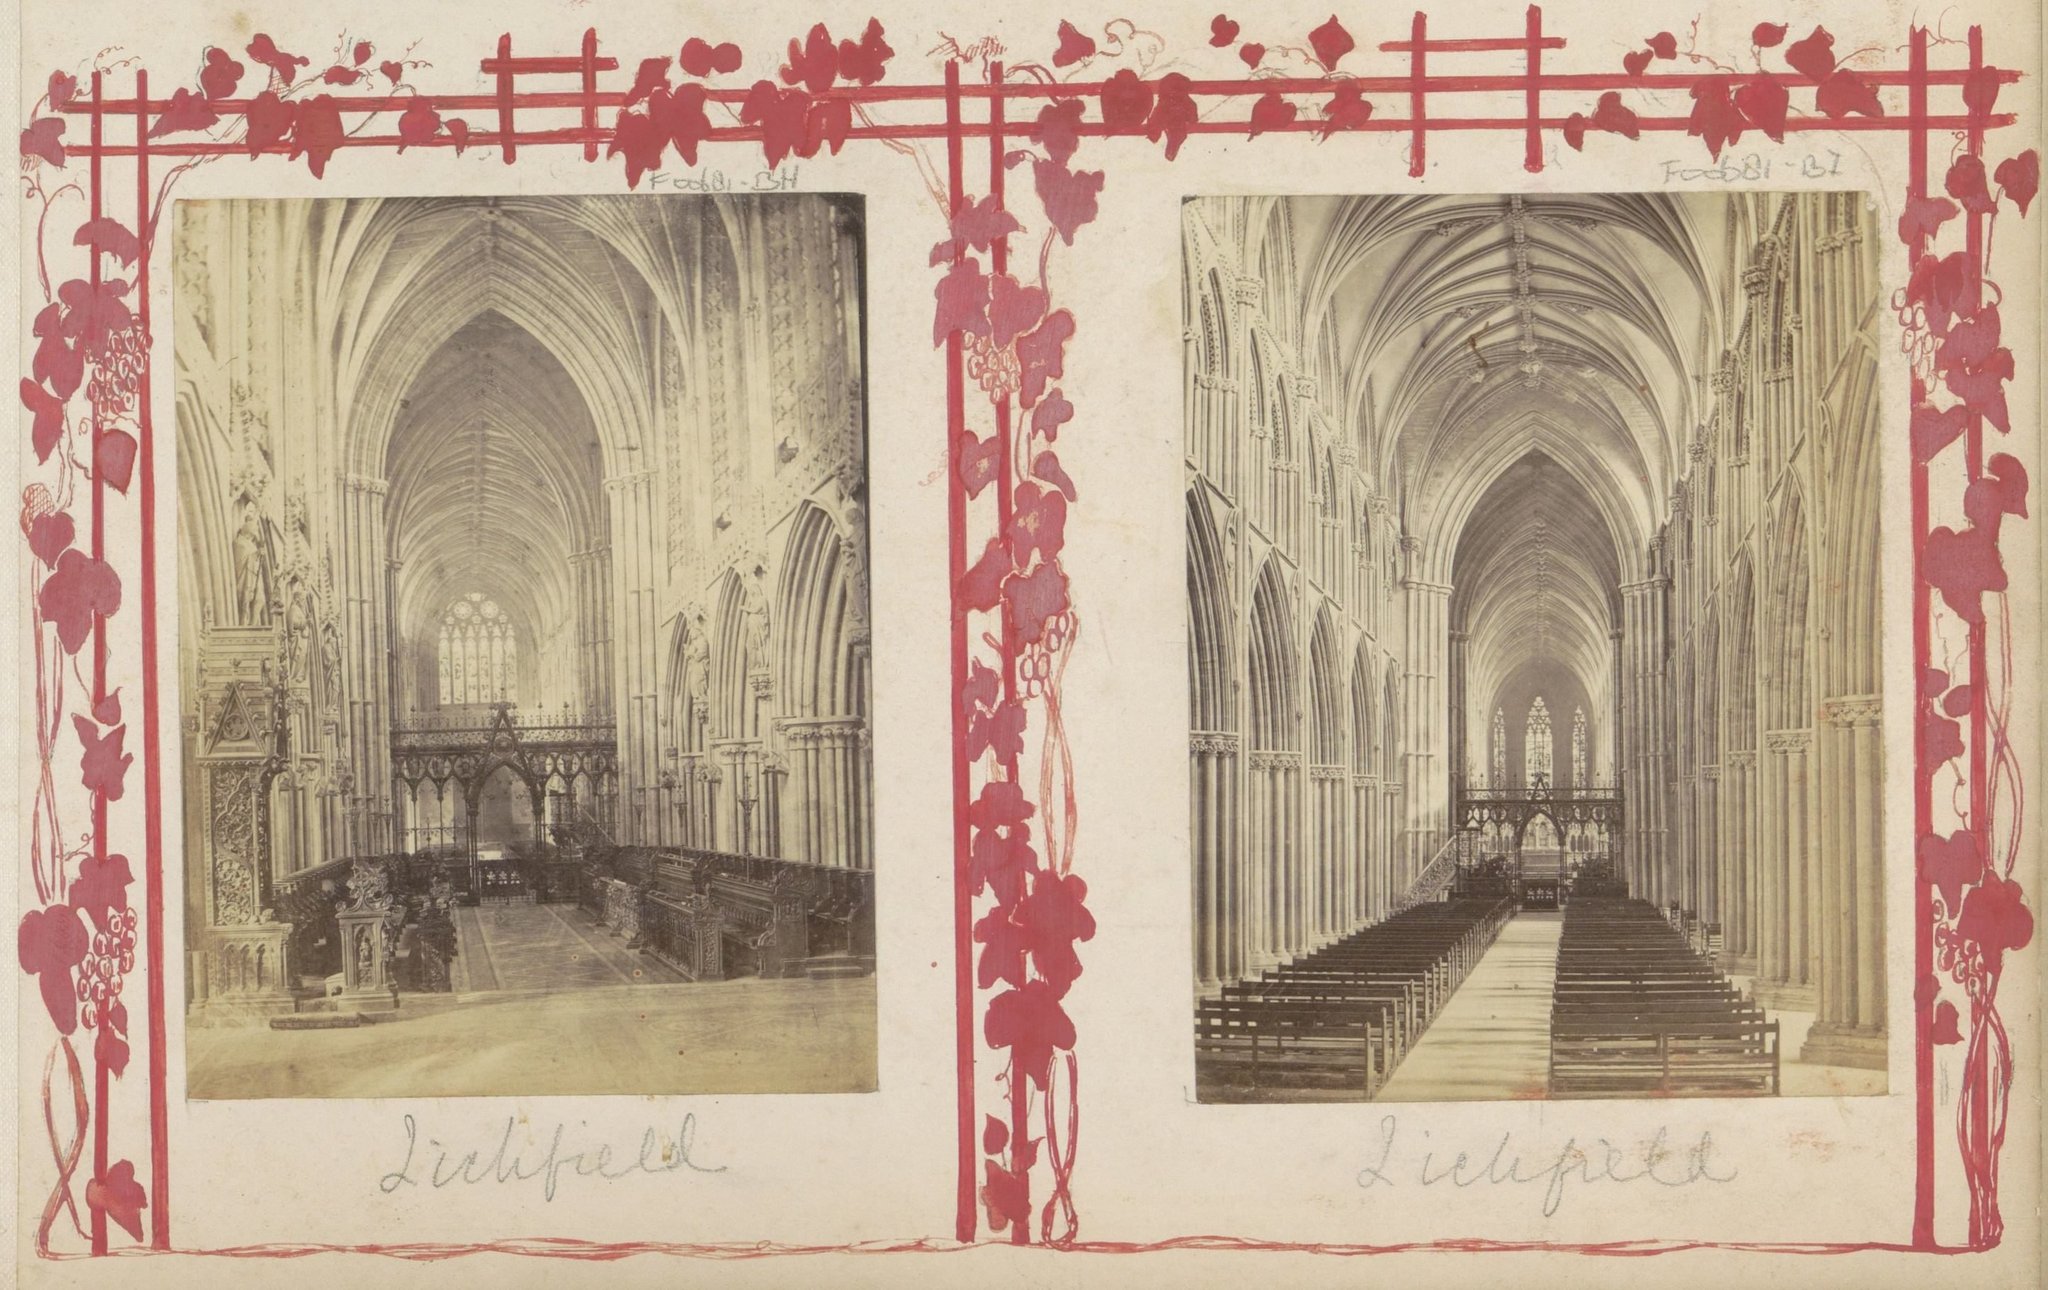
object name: photograph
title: Koor en koorhek van kathedraal van Lichfield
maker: Anonymous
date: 1850-1870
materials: paper, photographic support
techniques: albumen print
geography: lichfield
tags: rood-screen, choir-screen; iconostasis, parts of church interior: choir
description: Onderdeel van Album met foto's van bezienswaardigheden en landschappen in Engeland en van kunst.